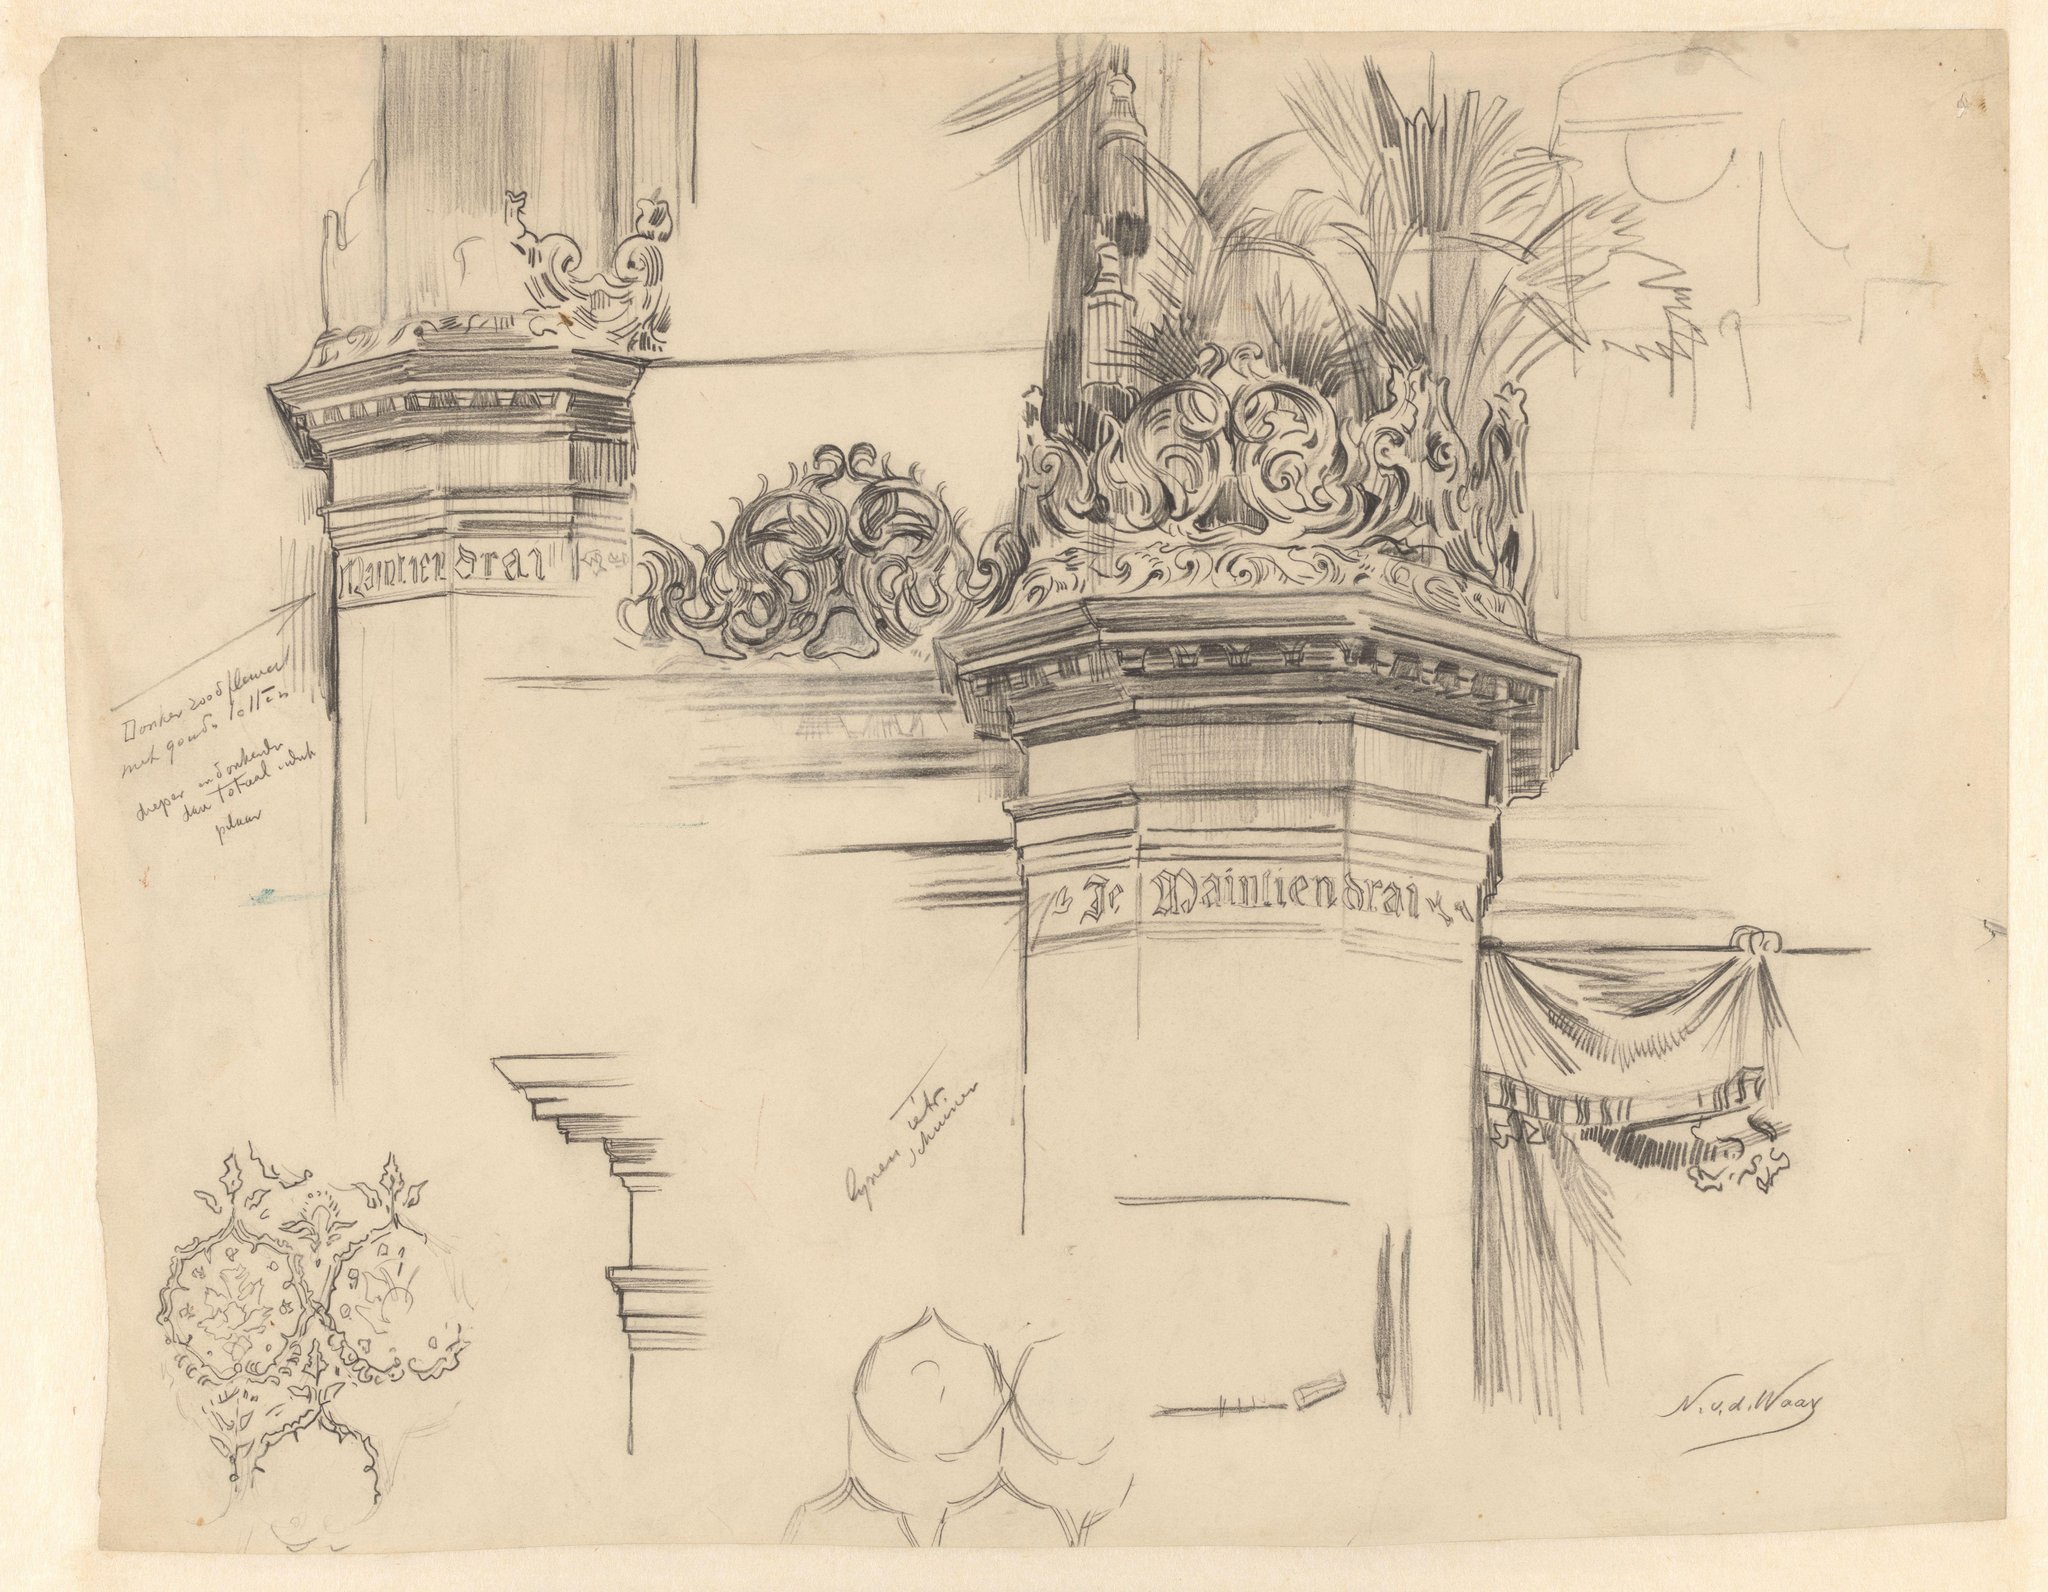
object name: drawing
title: Versierde kapitelen in de Nieuwe Kerk te Amsterdam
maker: nicolaas van der waay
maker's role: draughtsman, painter, print maker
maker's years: 1855-1936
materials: chalk, paper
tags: ornaments ~ art, capital (~ column, pillar)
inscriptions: collector's mark: Lugt 2228, annotation: ‘AJ 159/30’, :, number: ‘971.’, collector's mark: Lugt 2760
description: Studie voor het schilderij dat Nicolaas van der Waay maakte van de inhuldiging van Wilhelmina als koningin der Nederlanden in 1898 in de Nieuwe Kerk te Amsterdam.